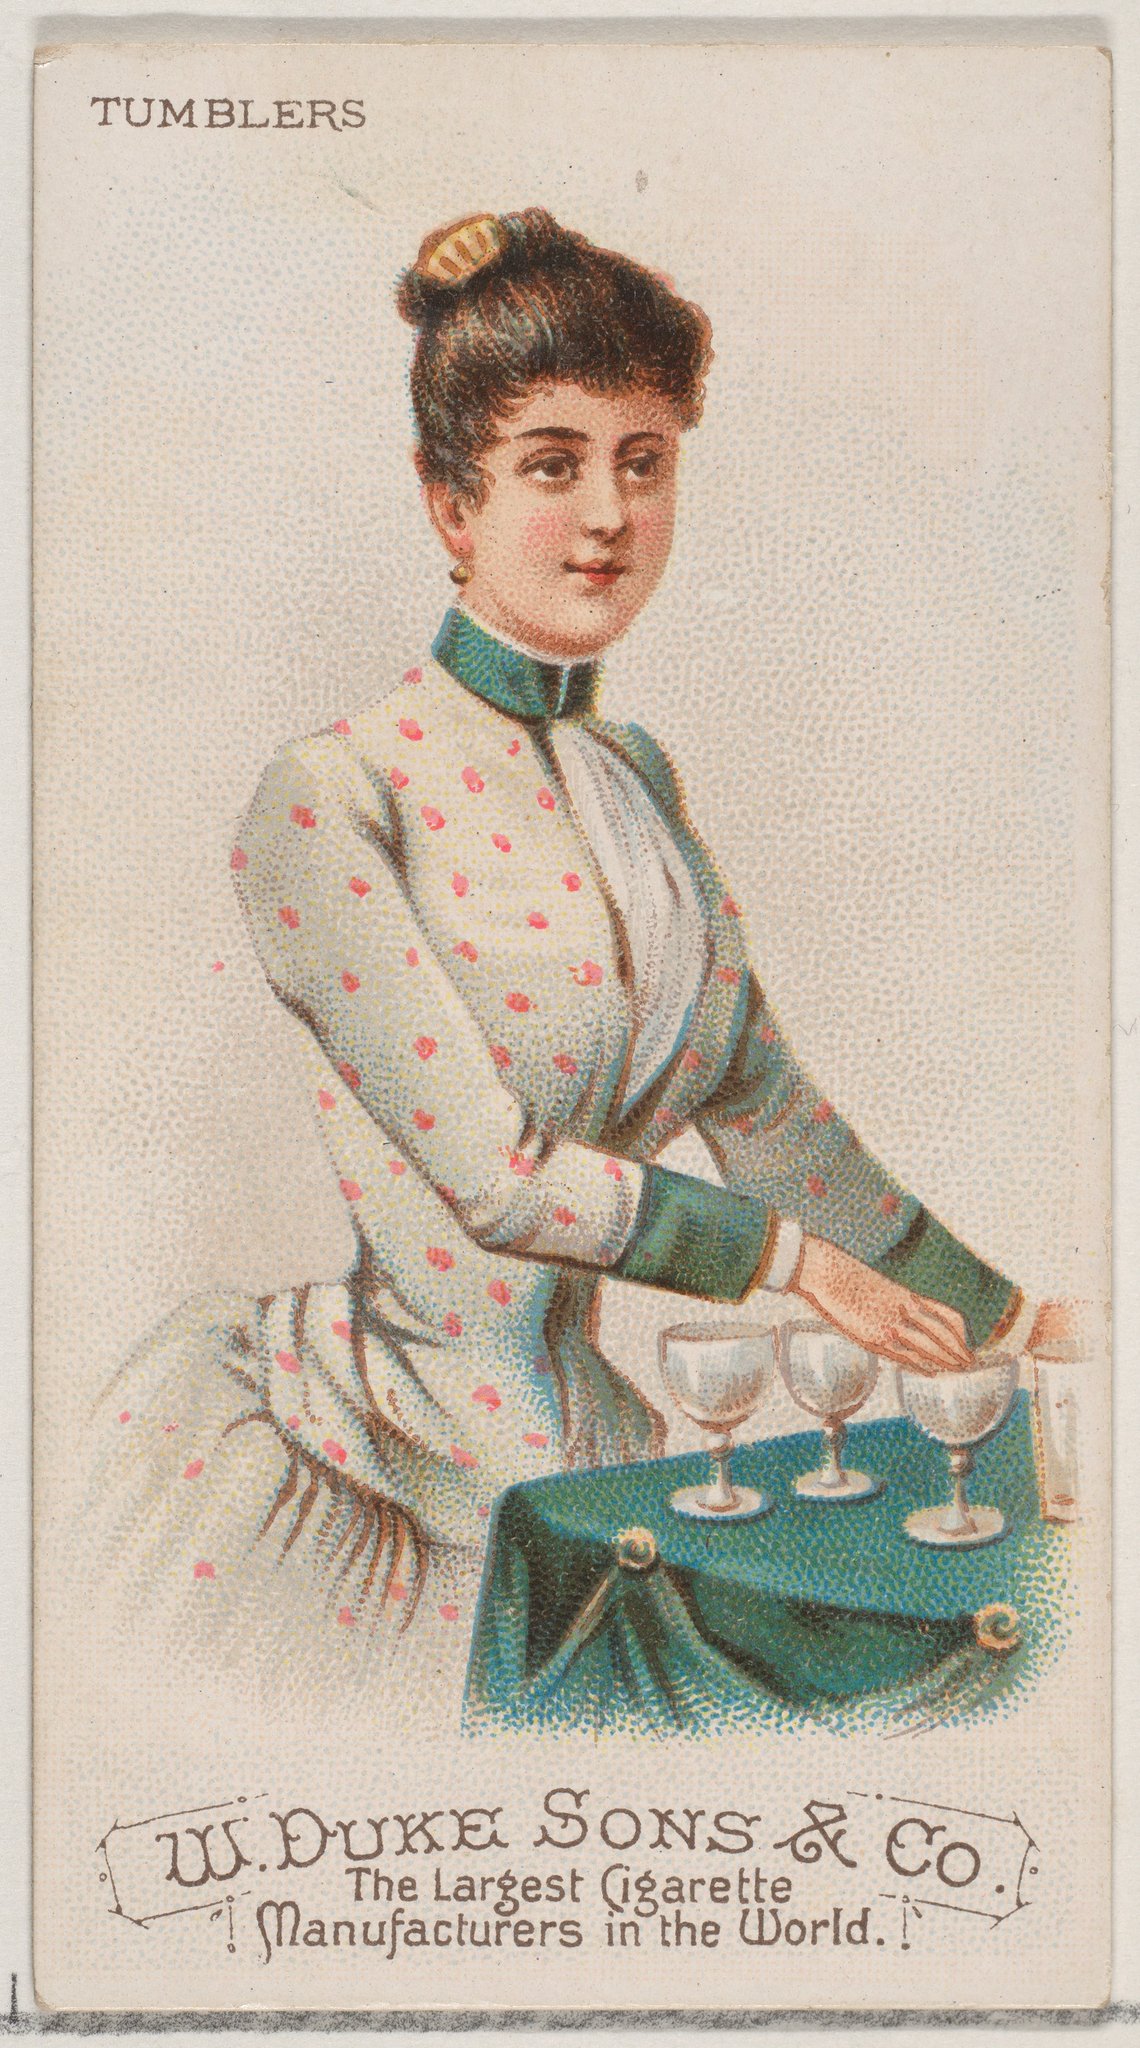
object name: print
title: Tumblers, from the Musical Instruments series (N82) for Duke brand cigarettes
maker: w. duke, sons & co.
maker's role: publisher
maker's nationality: american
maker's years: 1870-1920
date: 1888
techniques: color lithograph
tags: musical instruments,women,musicians